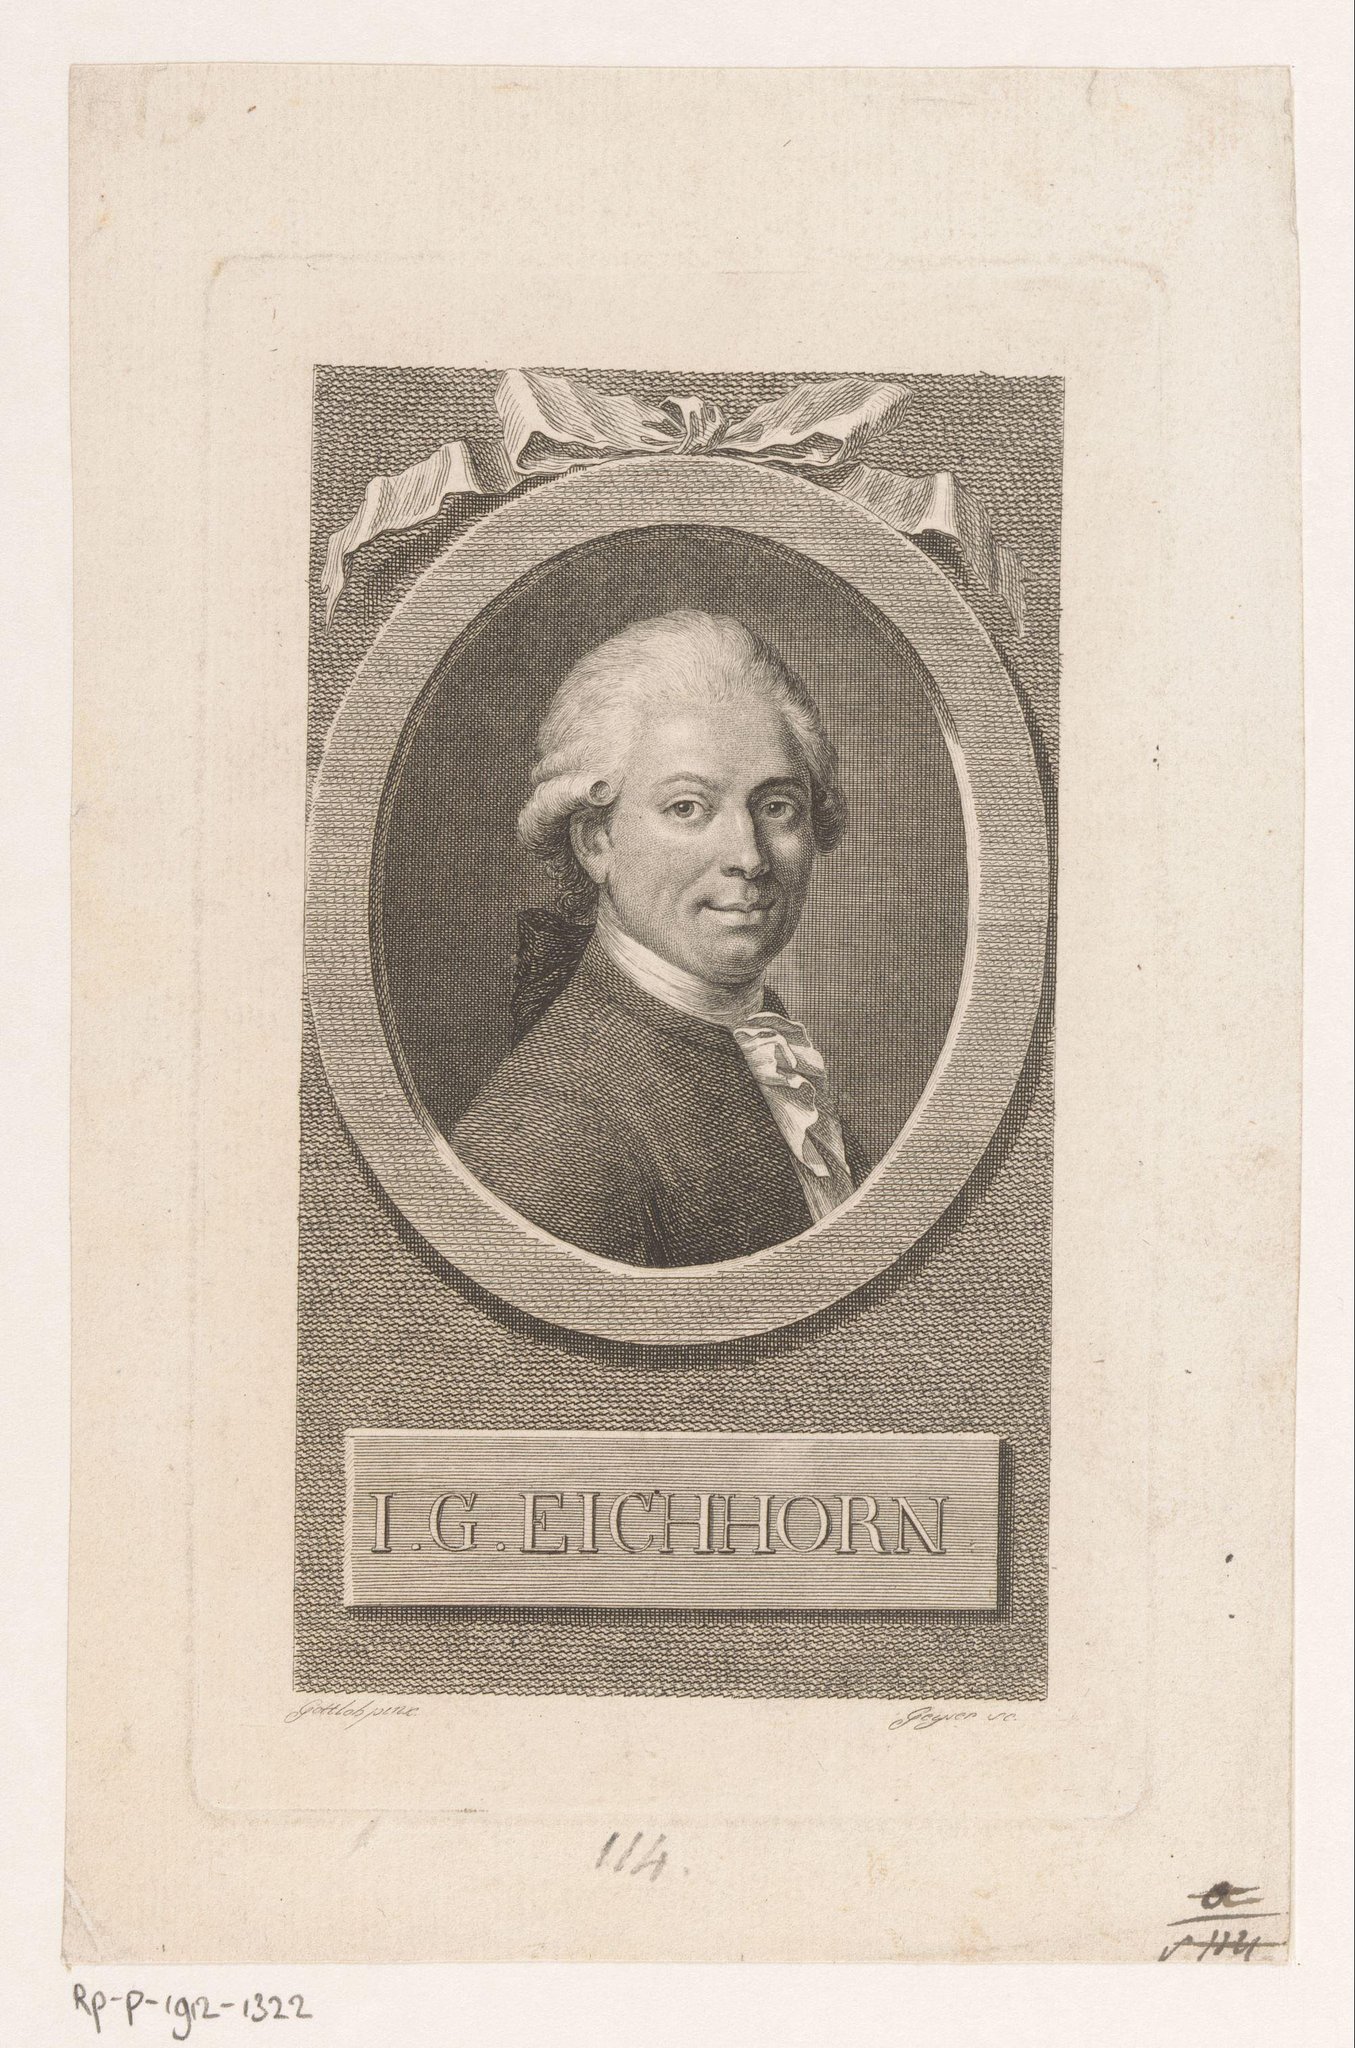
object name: print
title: Portret van Johann Gottfried Eichhorn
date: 1762-1803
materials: paper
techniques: engraving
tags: theologian, ornament ~ medallion, historical persons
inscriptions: collector's mark: Lugt 2228, collector's mark: Lugt 1388